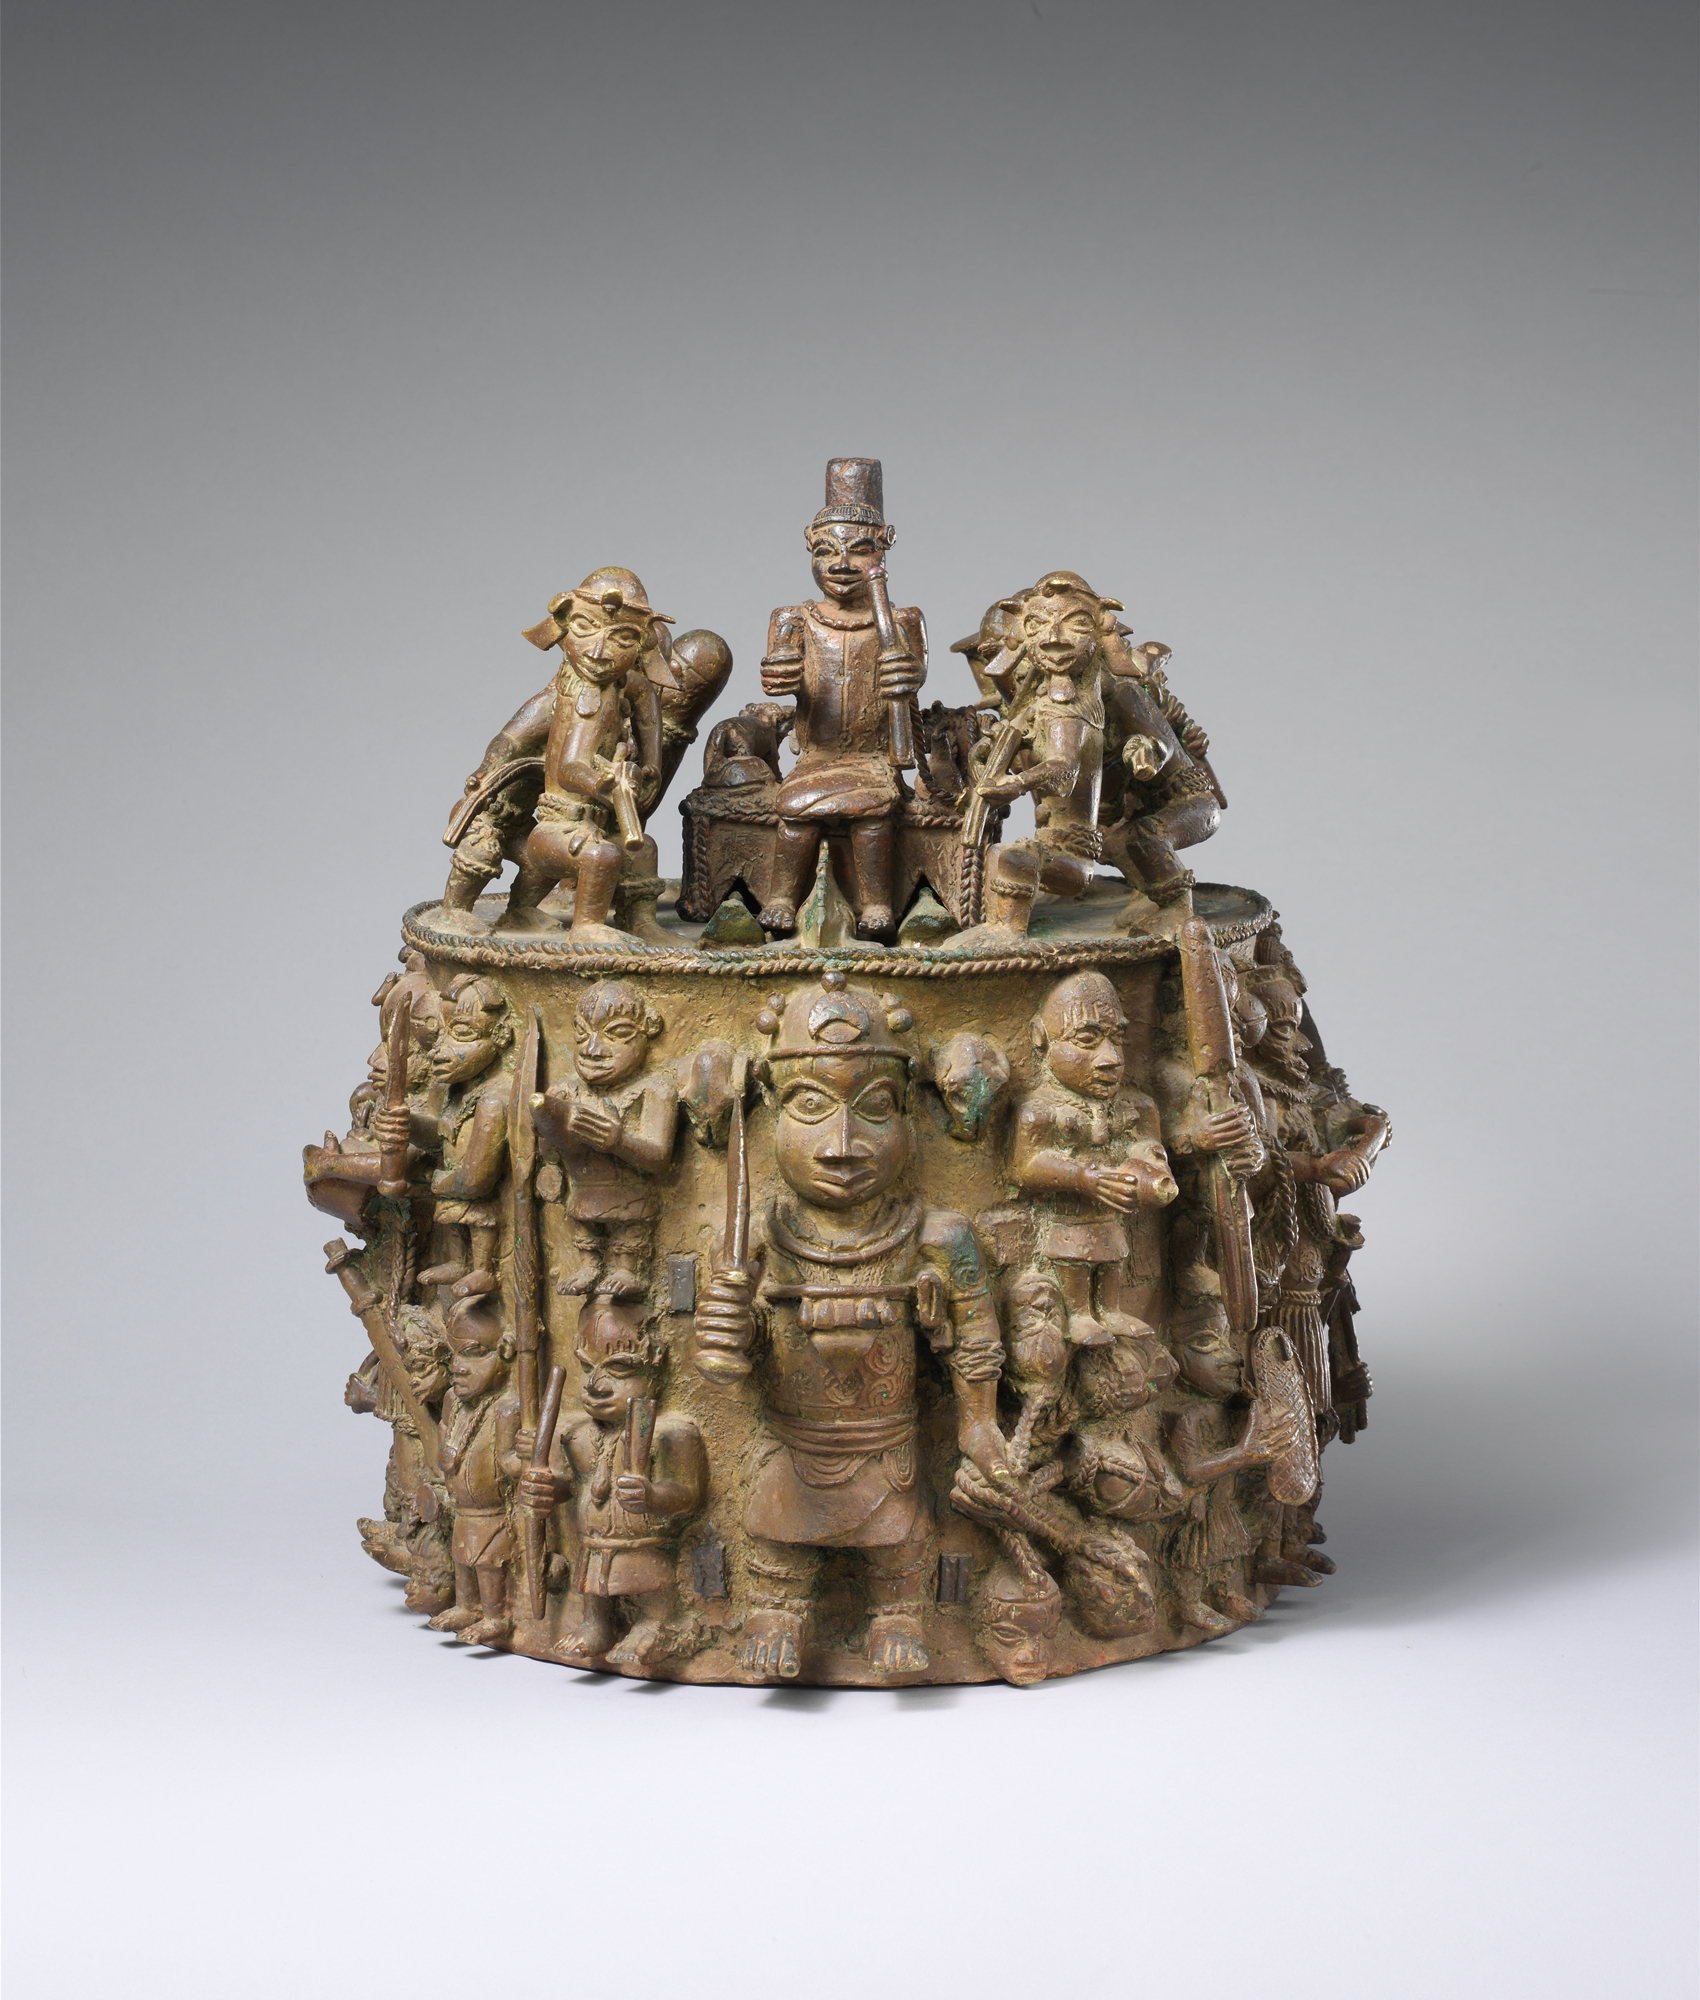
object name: altar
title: Oba with Animals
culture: edo period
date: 1701-1900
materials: brass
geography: nigeria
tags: weapons,swords,men,warriors